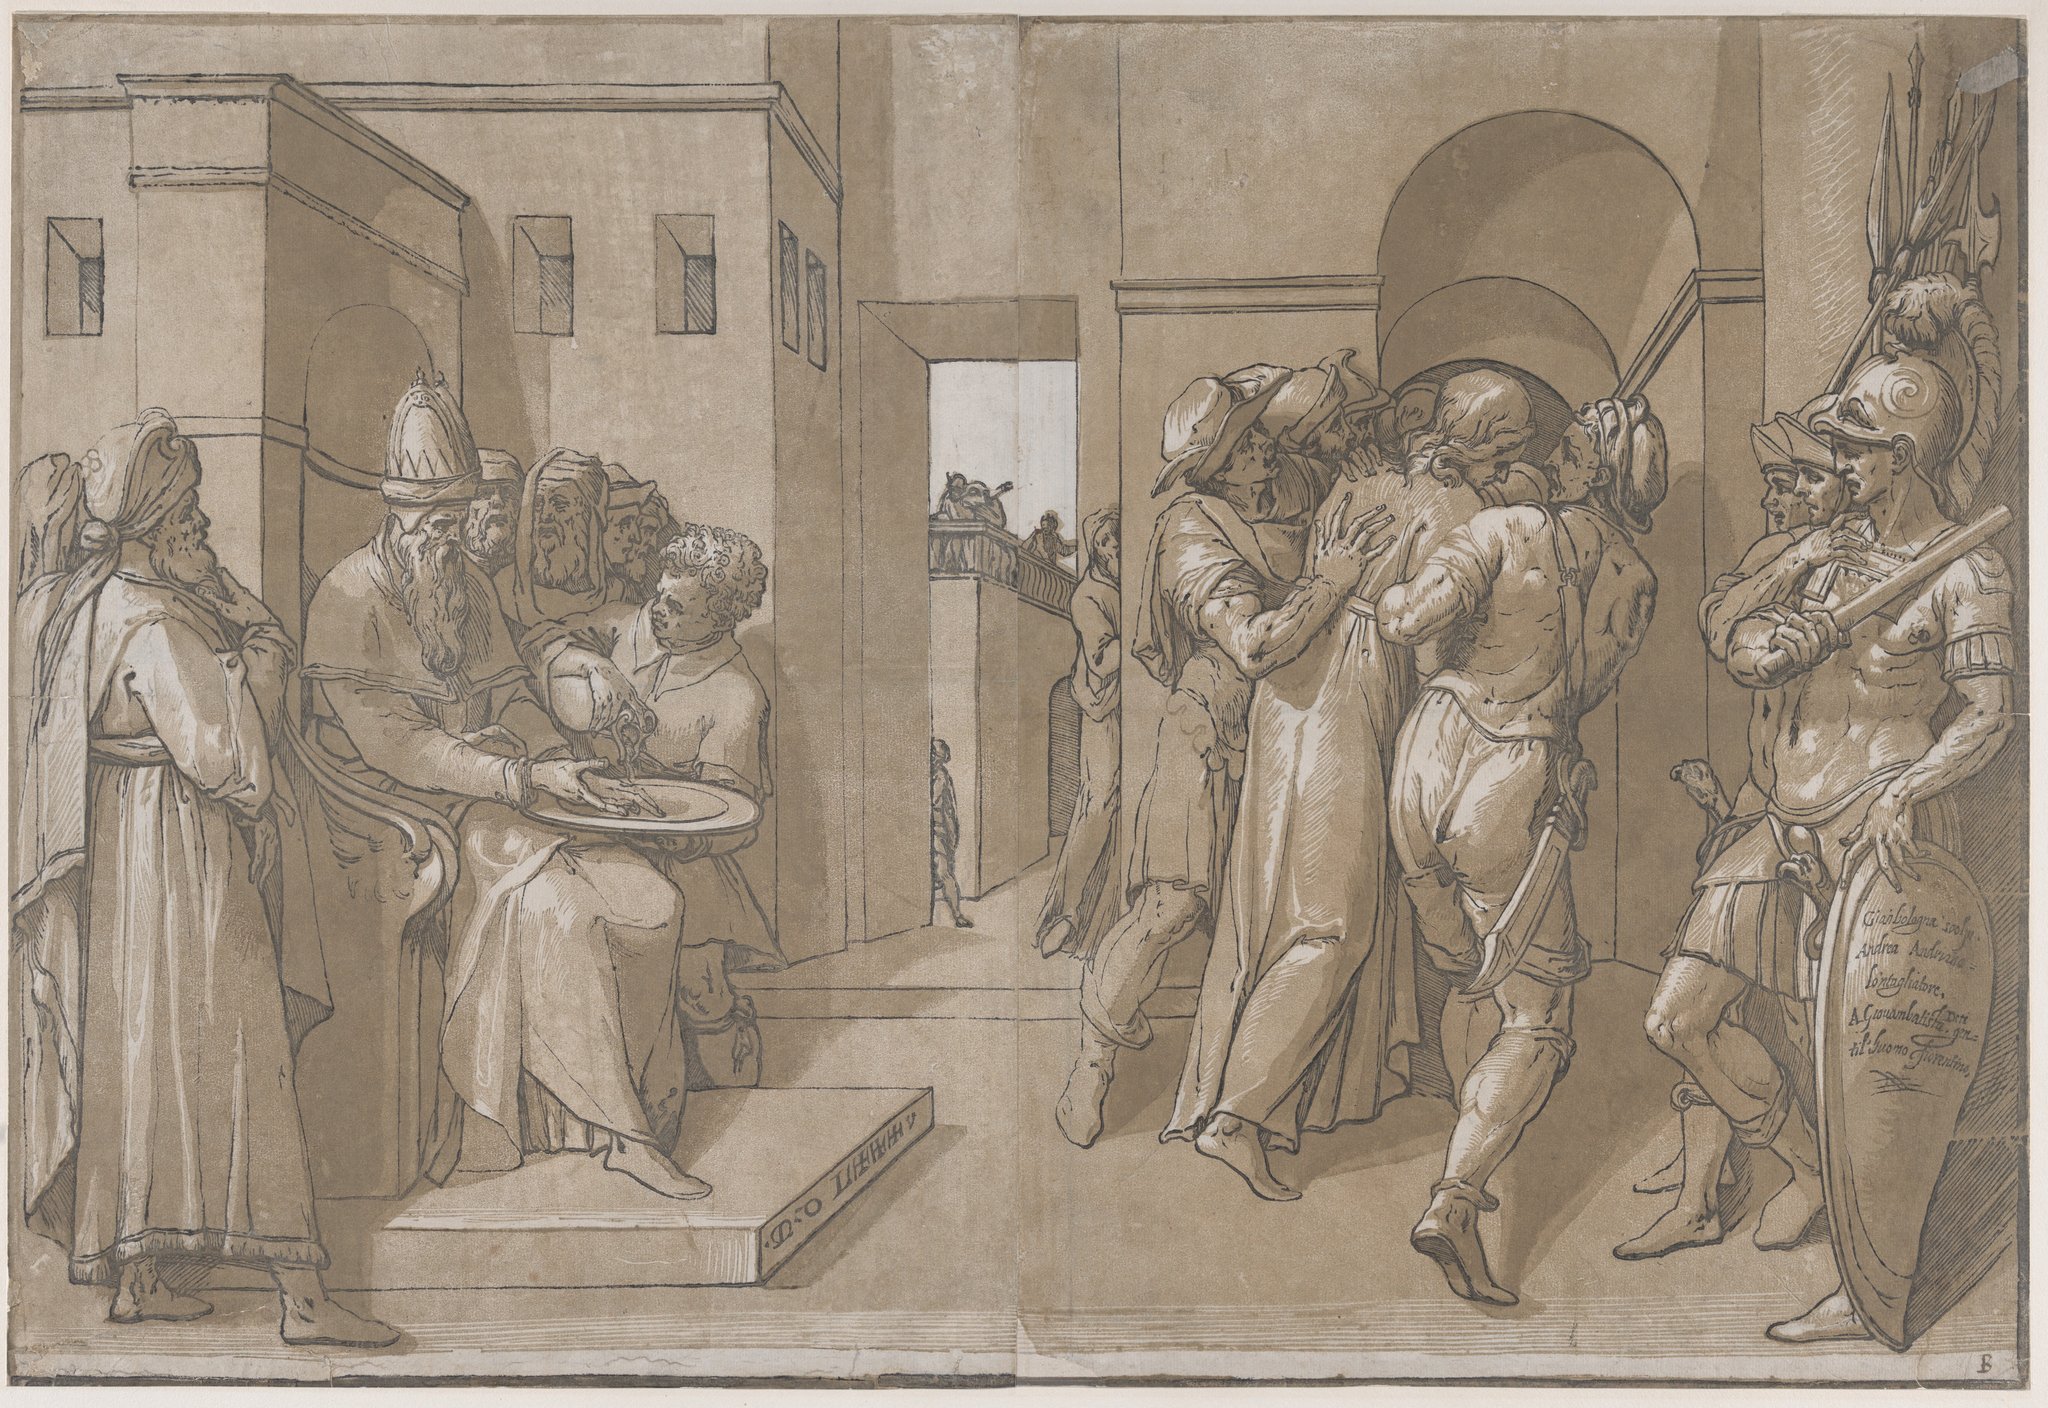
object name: print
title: Christ is being led away, soldiers stand at the right (right side of sheet)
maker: andrea andreani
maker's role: artist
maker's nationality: italian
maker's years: 1558-1629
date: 1585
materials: ink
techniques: woodcut, printing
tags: soldiers,christ